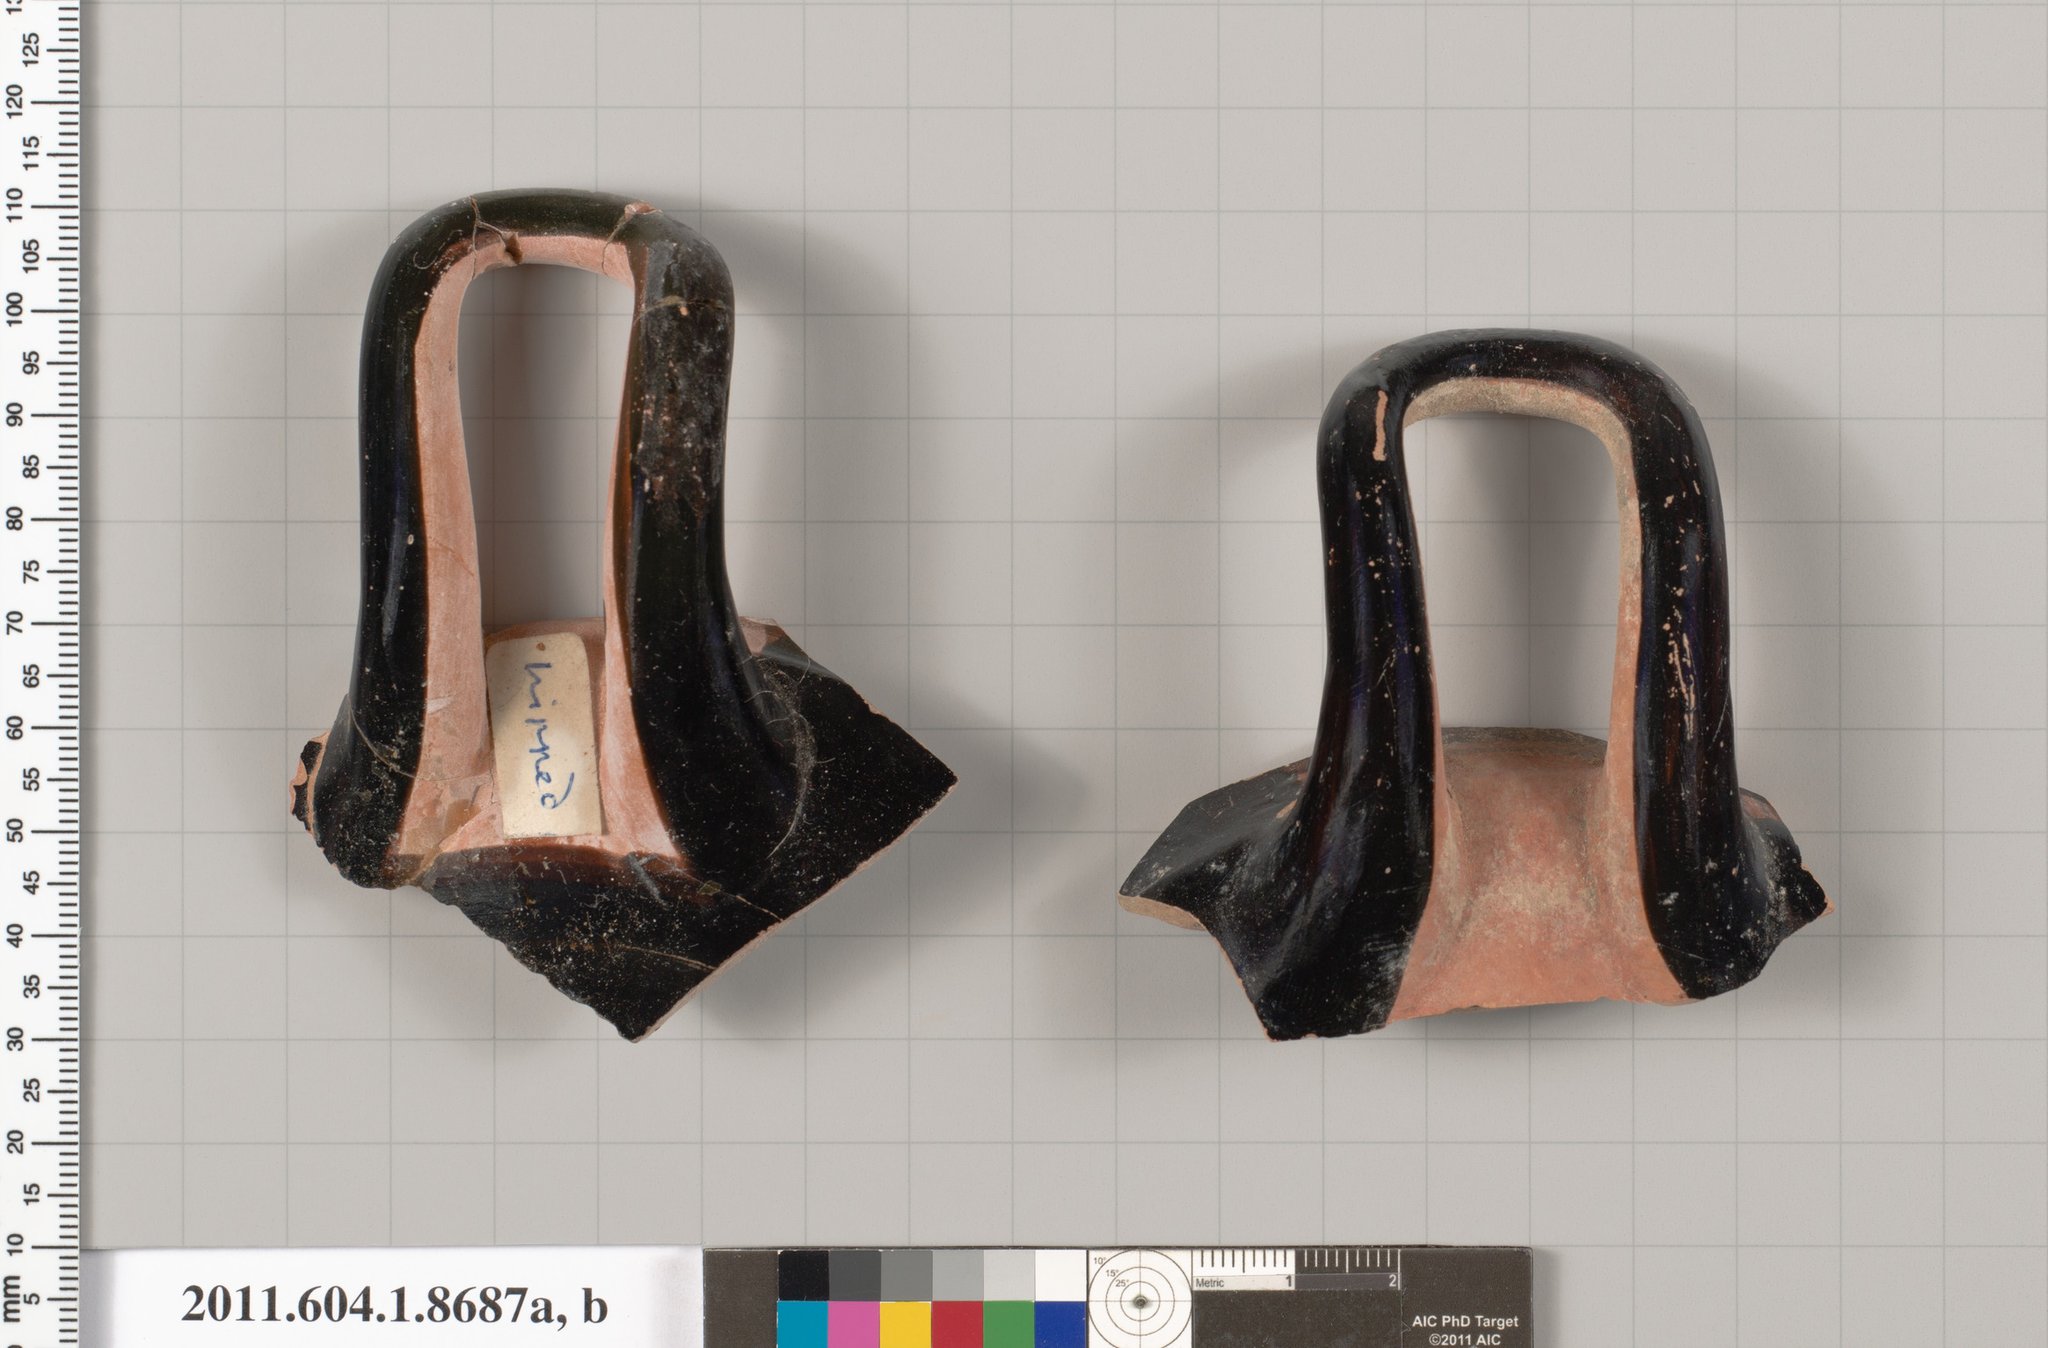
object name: kylix fragment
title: Terracotta fragments of stemless kylikes (drinking cups)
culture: greek, attic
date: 470-450 BCE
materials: terracotta